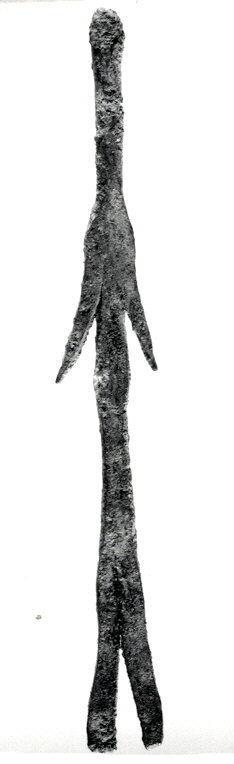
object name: figure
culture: middle niger civilization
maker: middle niger artist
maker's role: artist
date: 801-1700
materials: copper alloy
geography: mali